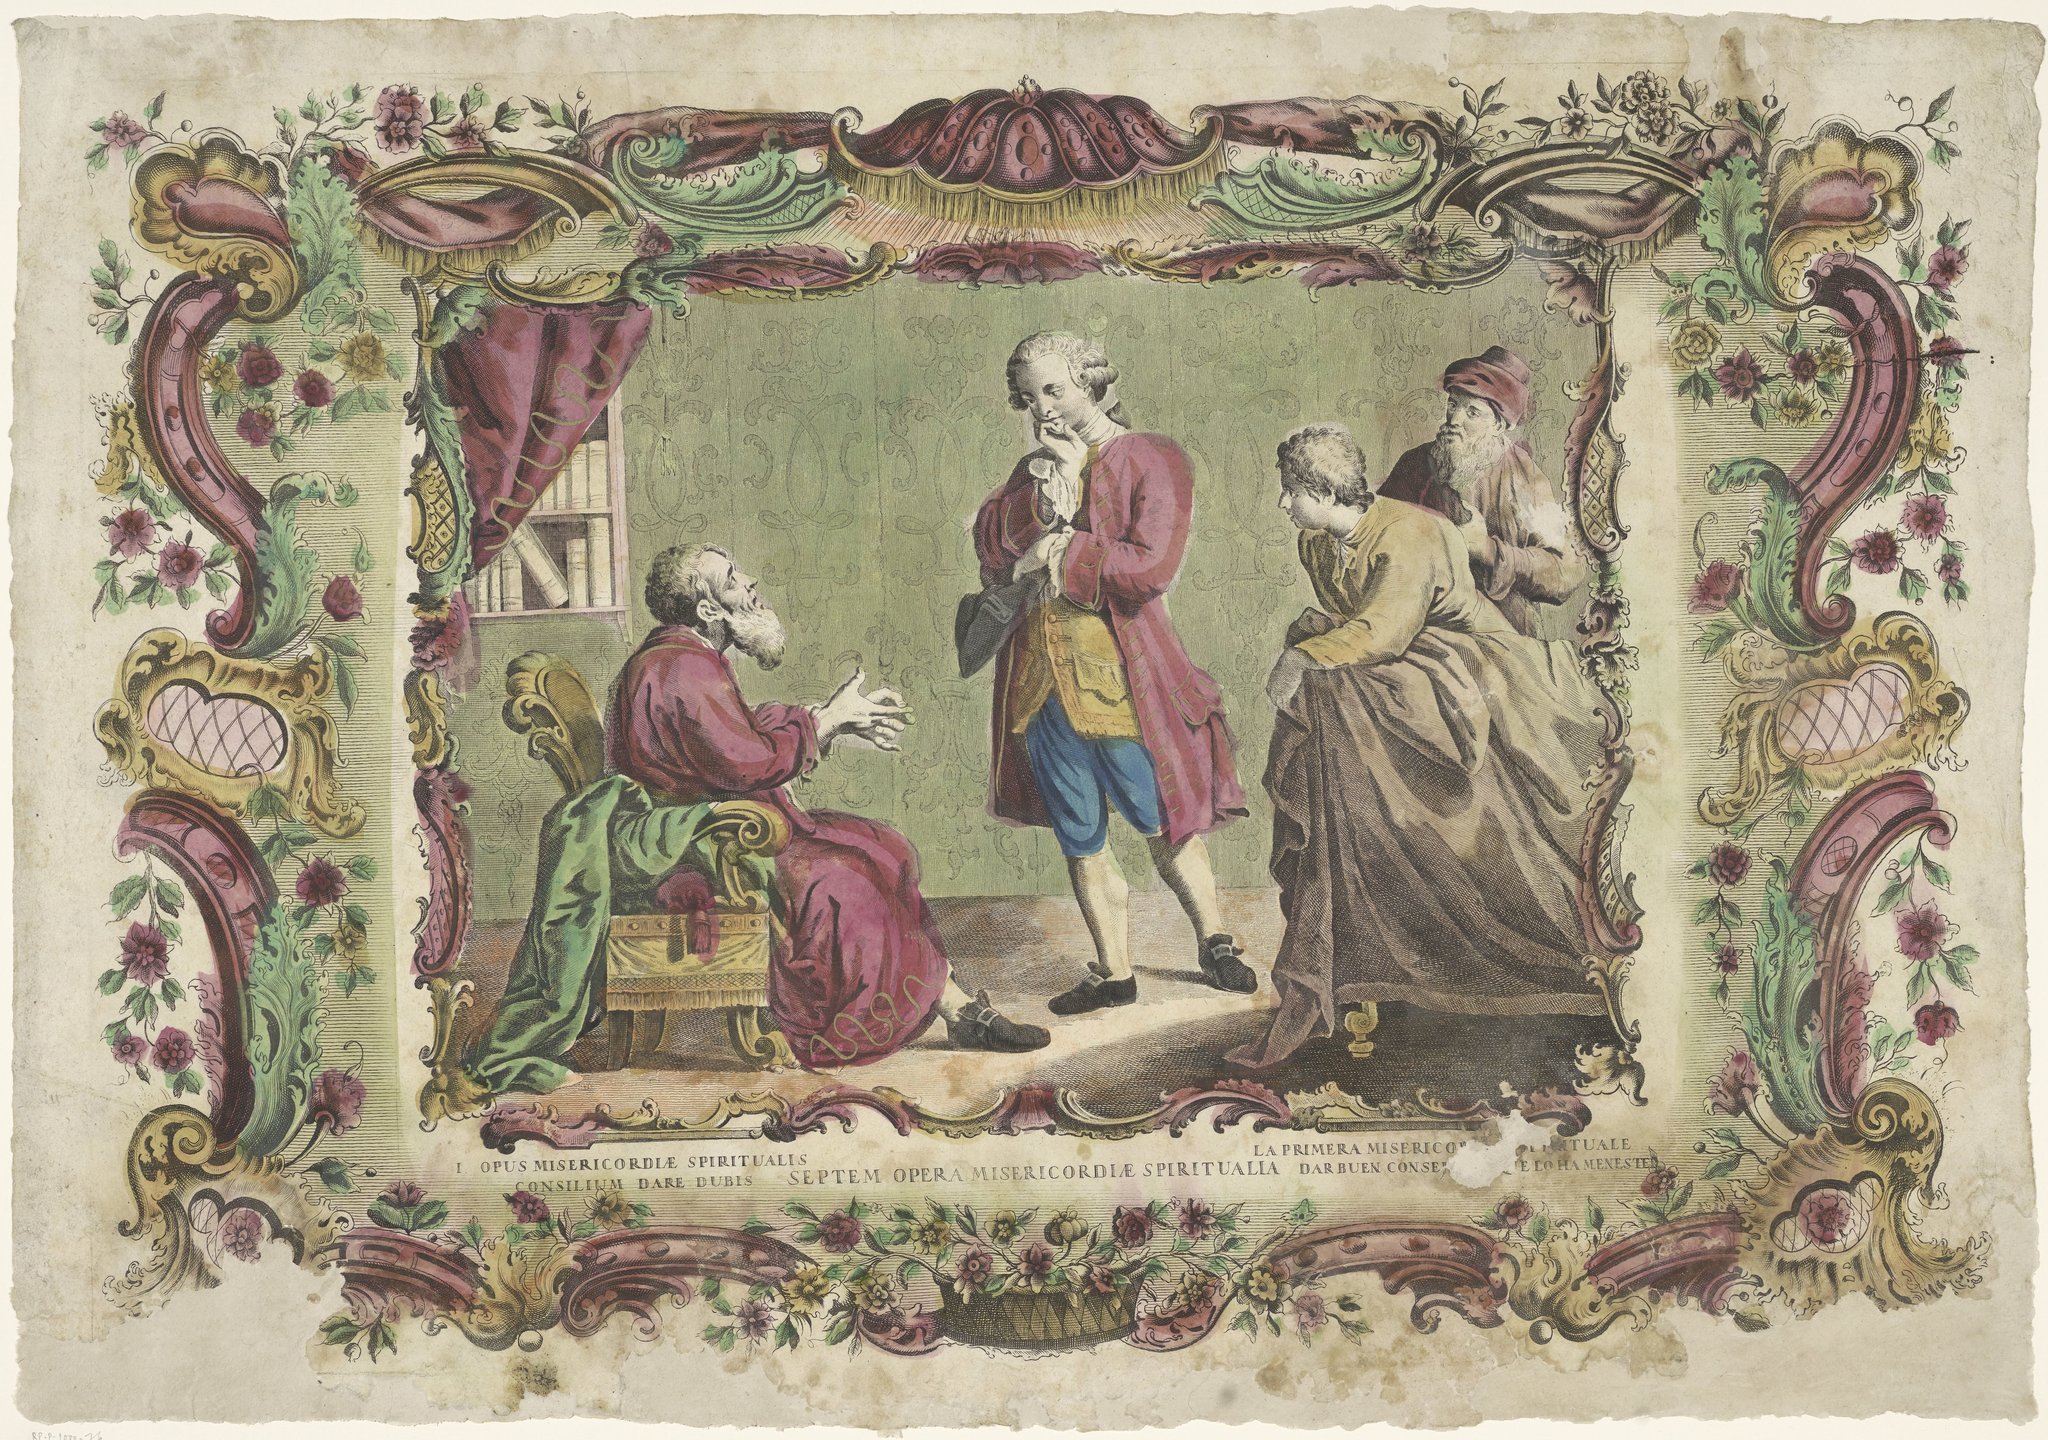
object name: print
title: I. Opus misericordia spiritualis / La primera misericordia spiritual (...).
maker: giovanni volpato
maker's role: ceramicist, print maker, printer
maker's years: 1735-1803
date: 1700-1799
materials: paper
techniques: colour, engraving, etching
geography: italy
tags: ornaments ~ art, warning sinners ~ one of the (seven) spiritual acts of mercy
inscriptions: collector's mark: Lugt 2760, collector's mark: Lugt 2228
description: Uitbeelding van één van de spirituele werken van barmhartigheid: het waarschuwen van zondaars. In een vertrek zit een oude man in een leunstoel. Hij maakt een spreekgebaar. Voor hem staat een jongeman in peinzende houding naar hem te luisteren. Rechts een oude en een jongeman die toehoren. Titel onder voorstelling. De scène is gevat in een ornamentrand.